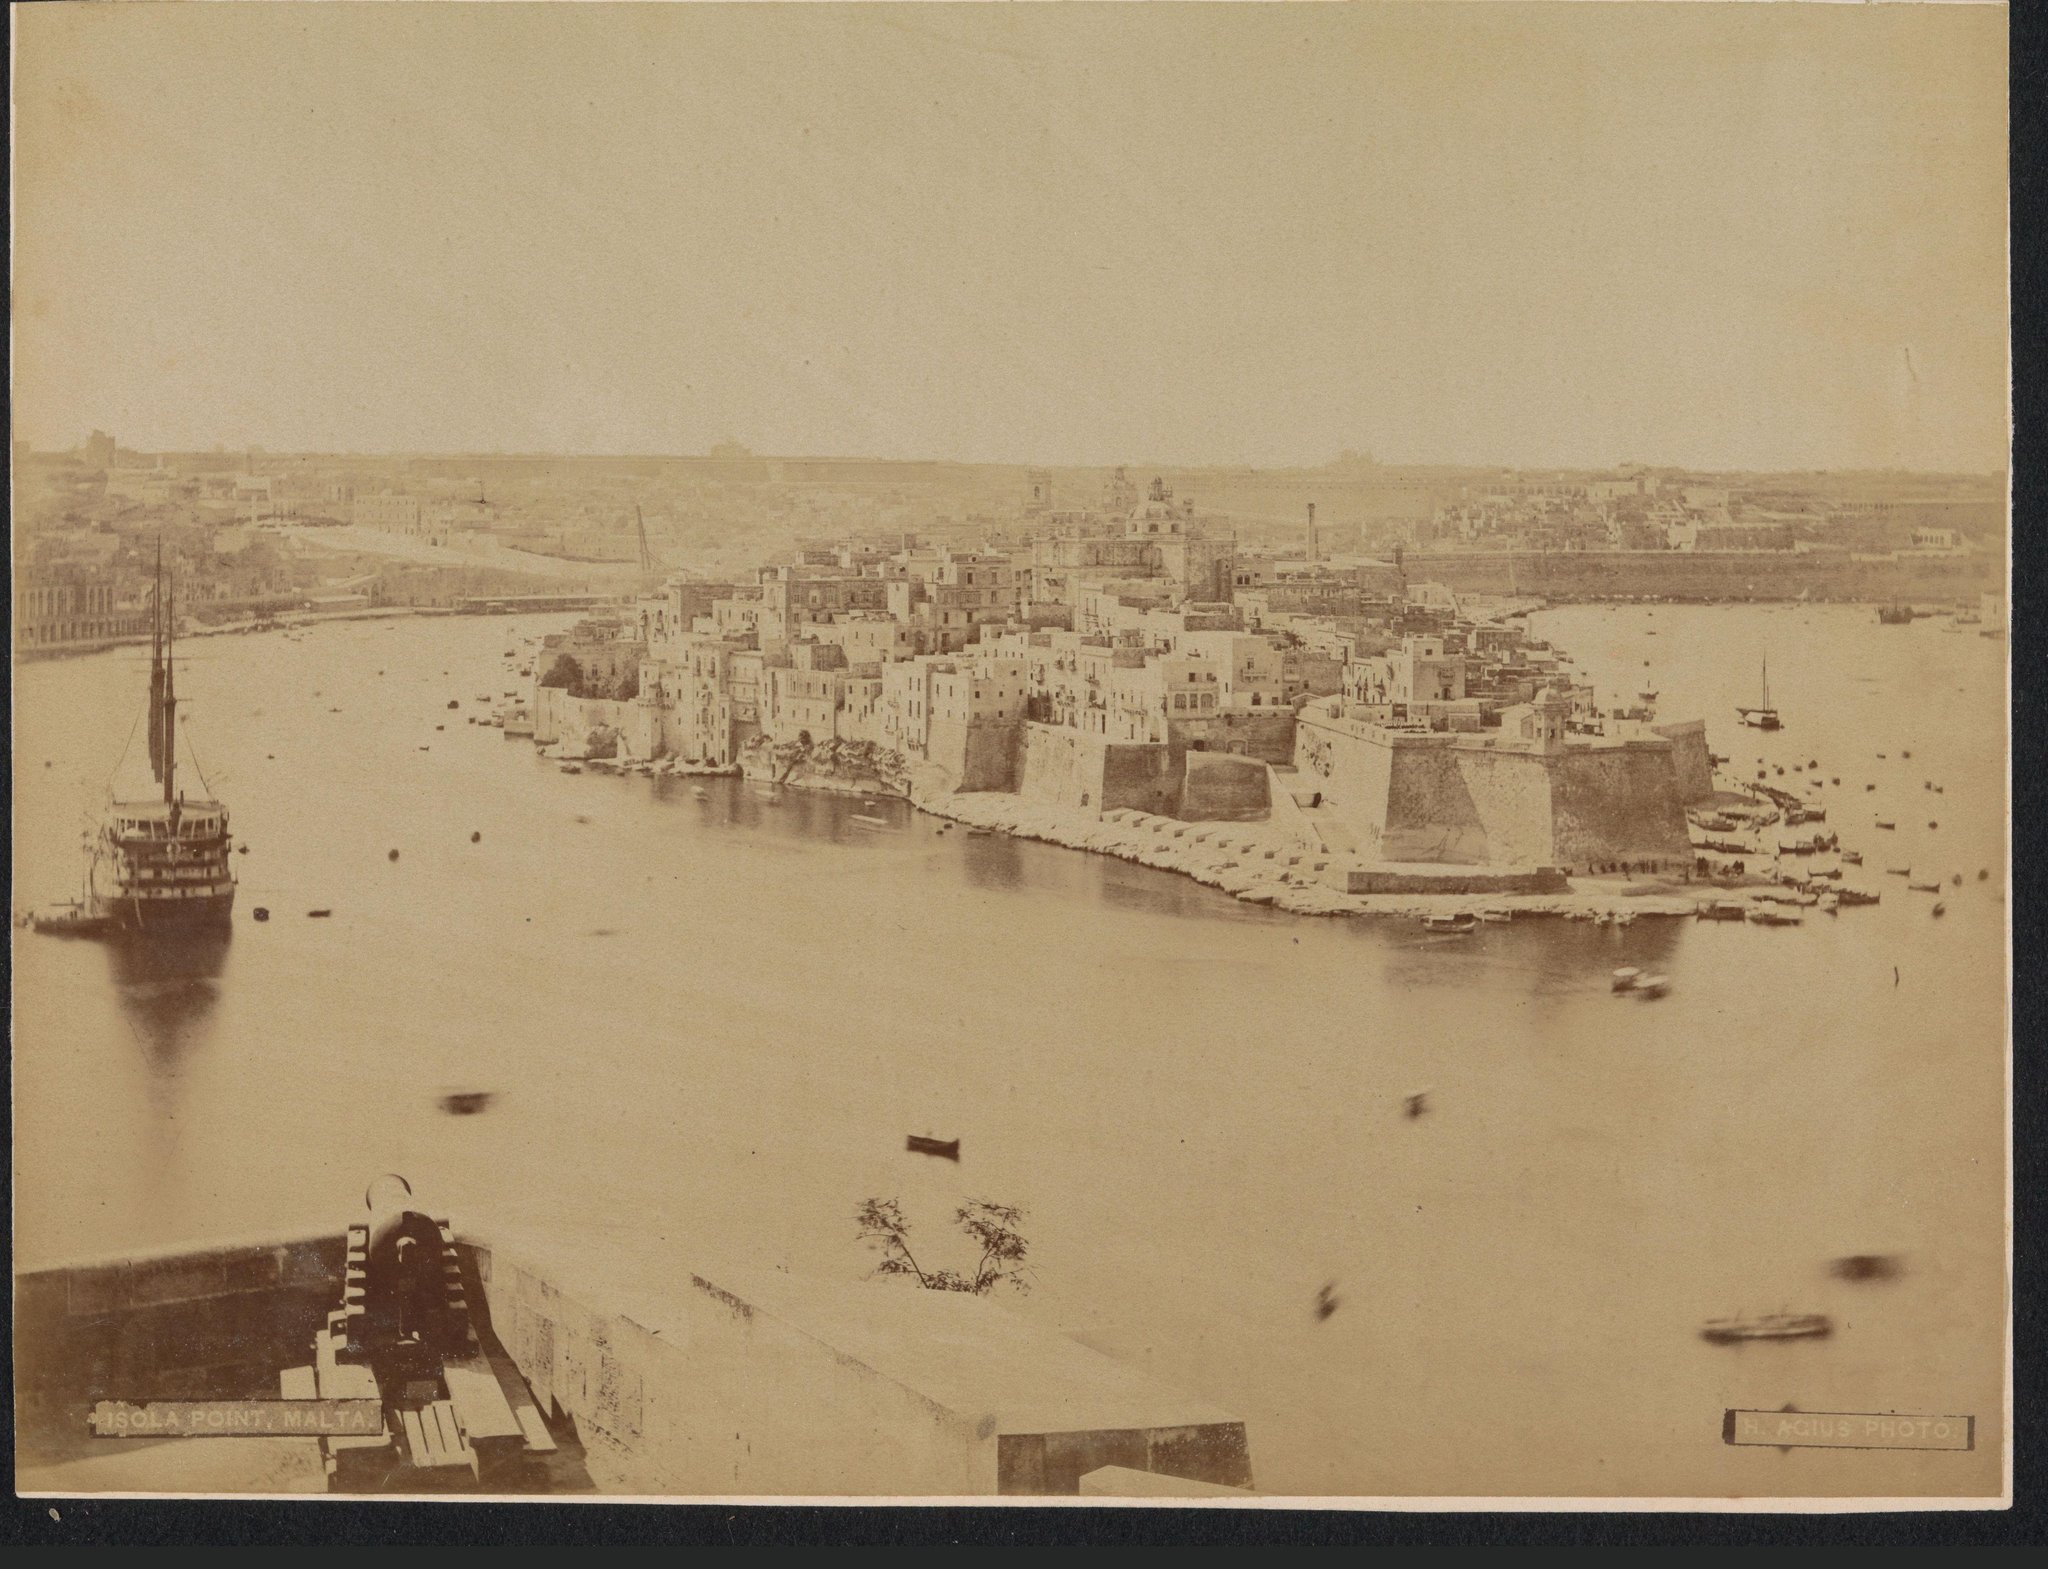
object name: photograph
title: Isola Point Malta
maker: horatio agius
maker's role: fotograaf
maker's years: 1844-1910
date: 1860-1910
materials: paper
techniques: albumen print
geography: valletta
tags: harbour, city-view in general; 'veduta', ships (in general) - cc - more than one ship